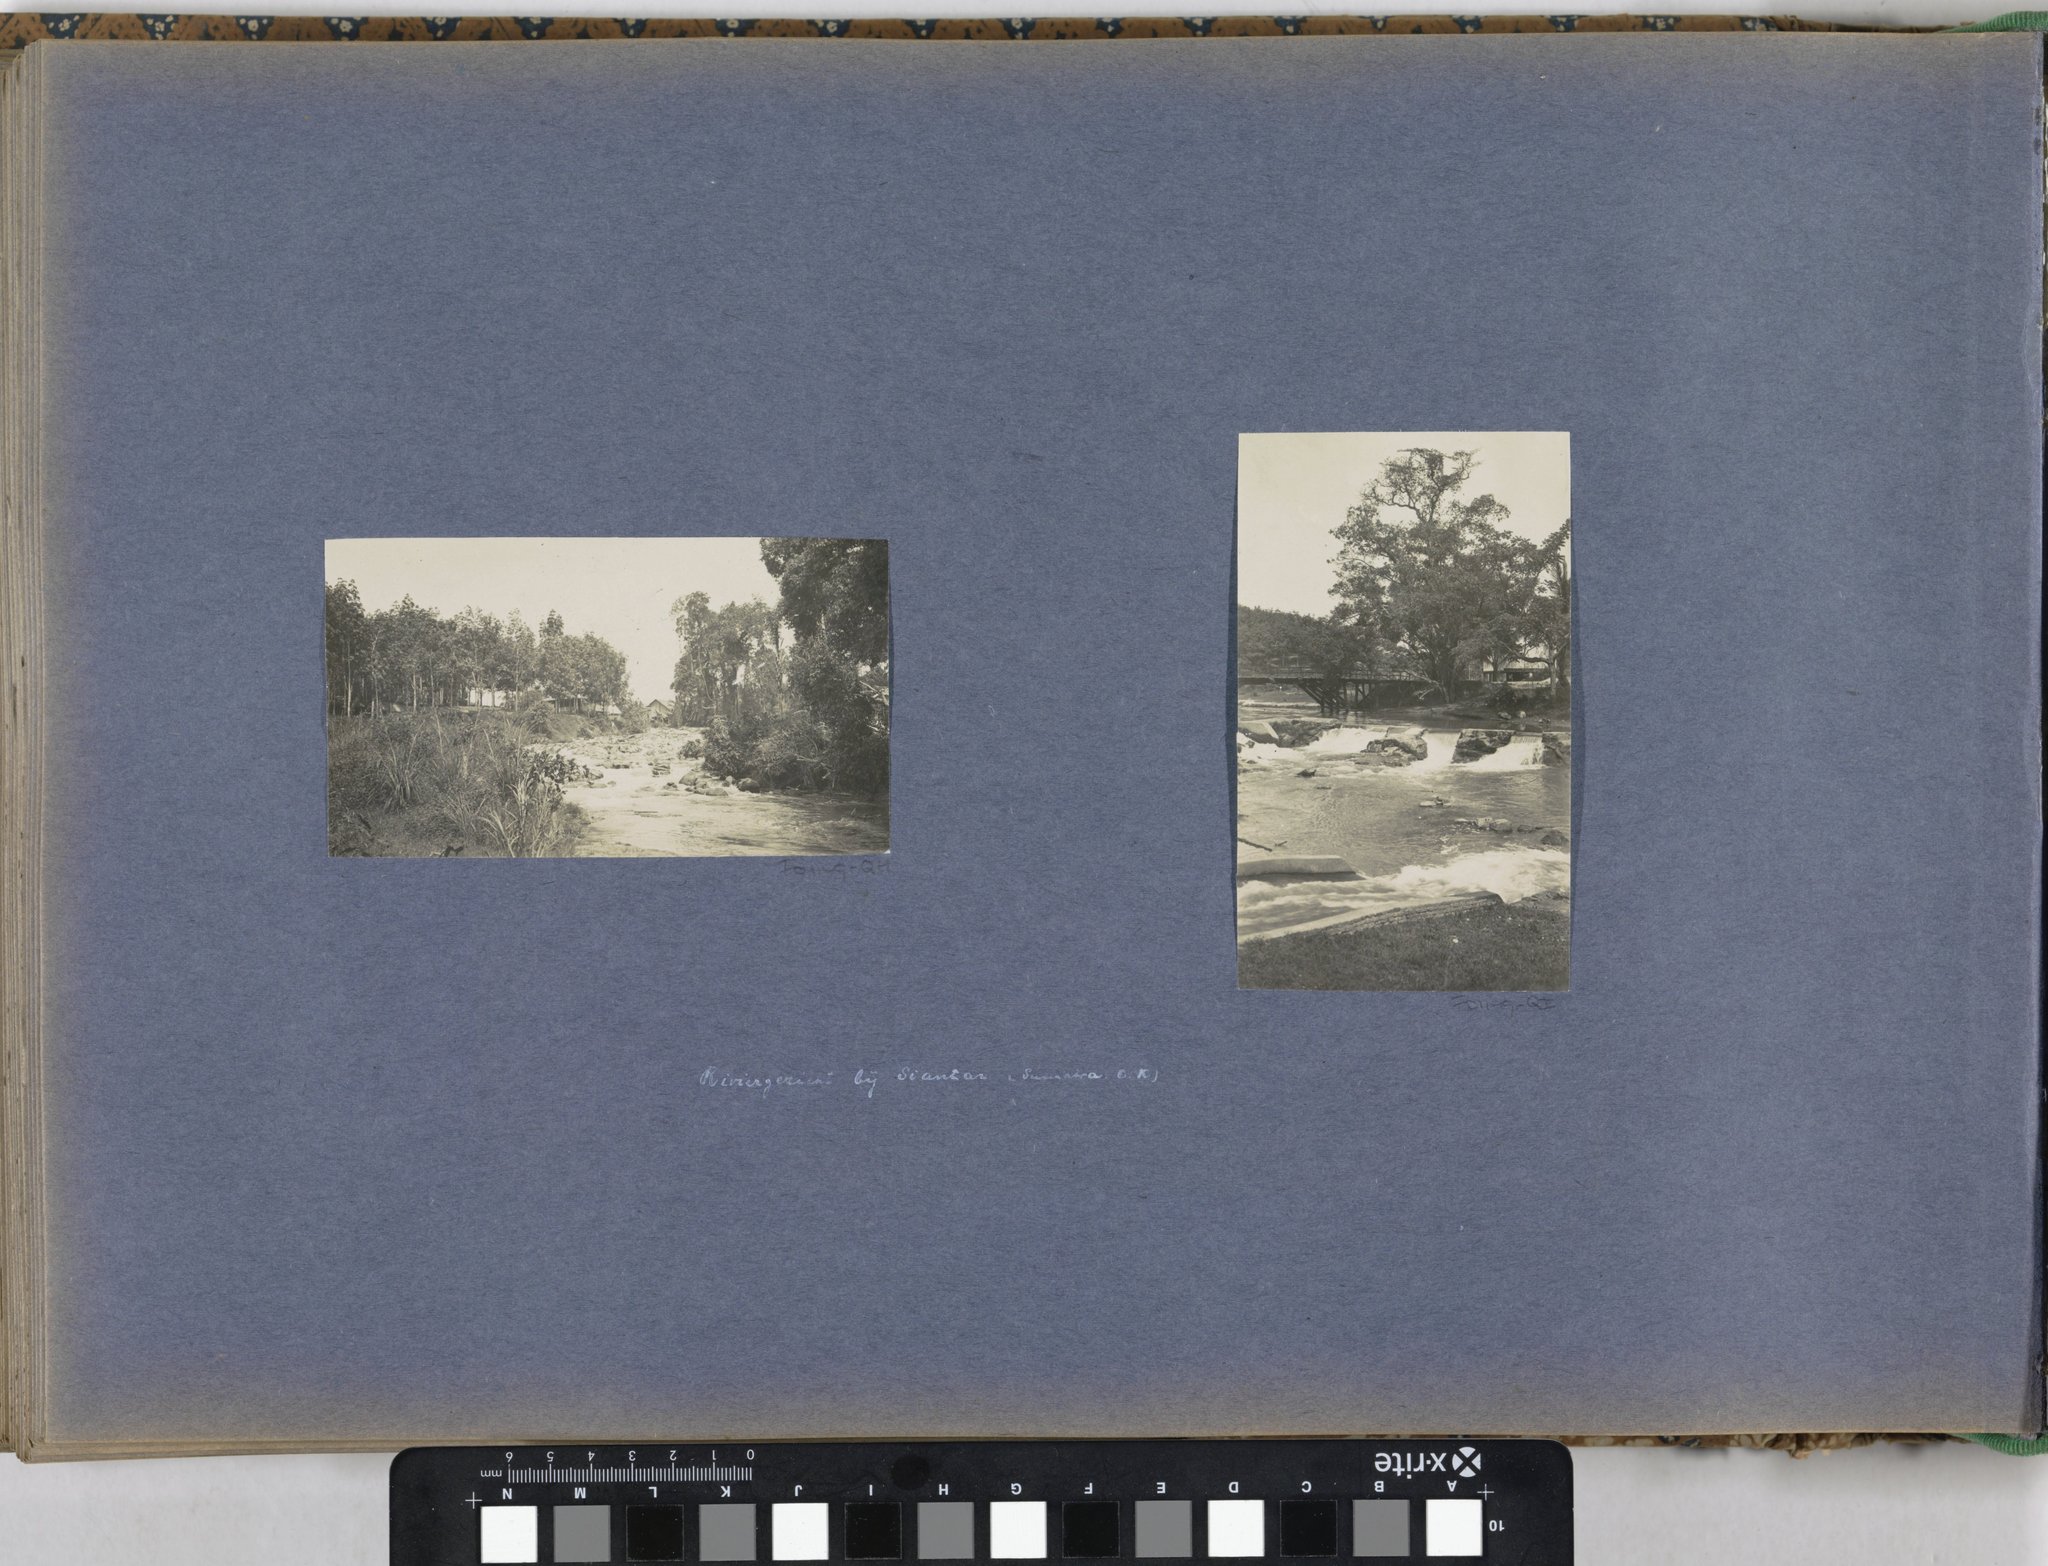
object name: album leaf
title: Riviergezicht bij Siantar op Sumatra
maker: Anonymous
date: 1900-1920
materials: paper, photographic support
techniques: gelatin silver print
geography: sumatra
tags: river (+ landscape with figures, staffage), sumatra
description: Onderdeel van reisalbum met foto's van bedrijvigheid en bezienswaardigheden op Sumatra en Java en van de reis naar en van Nederlands-Indië.